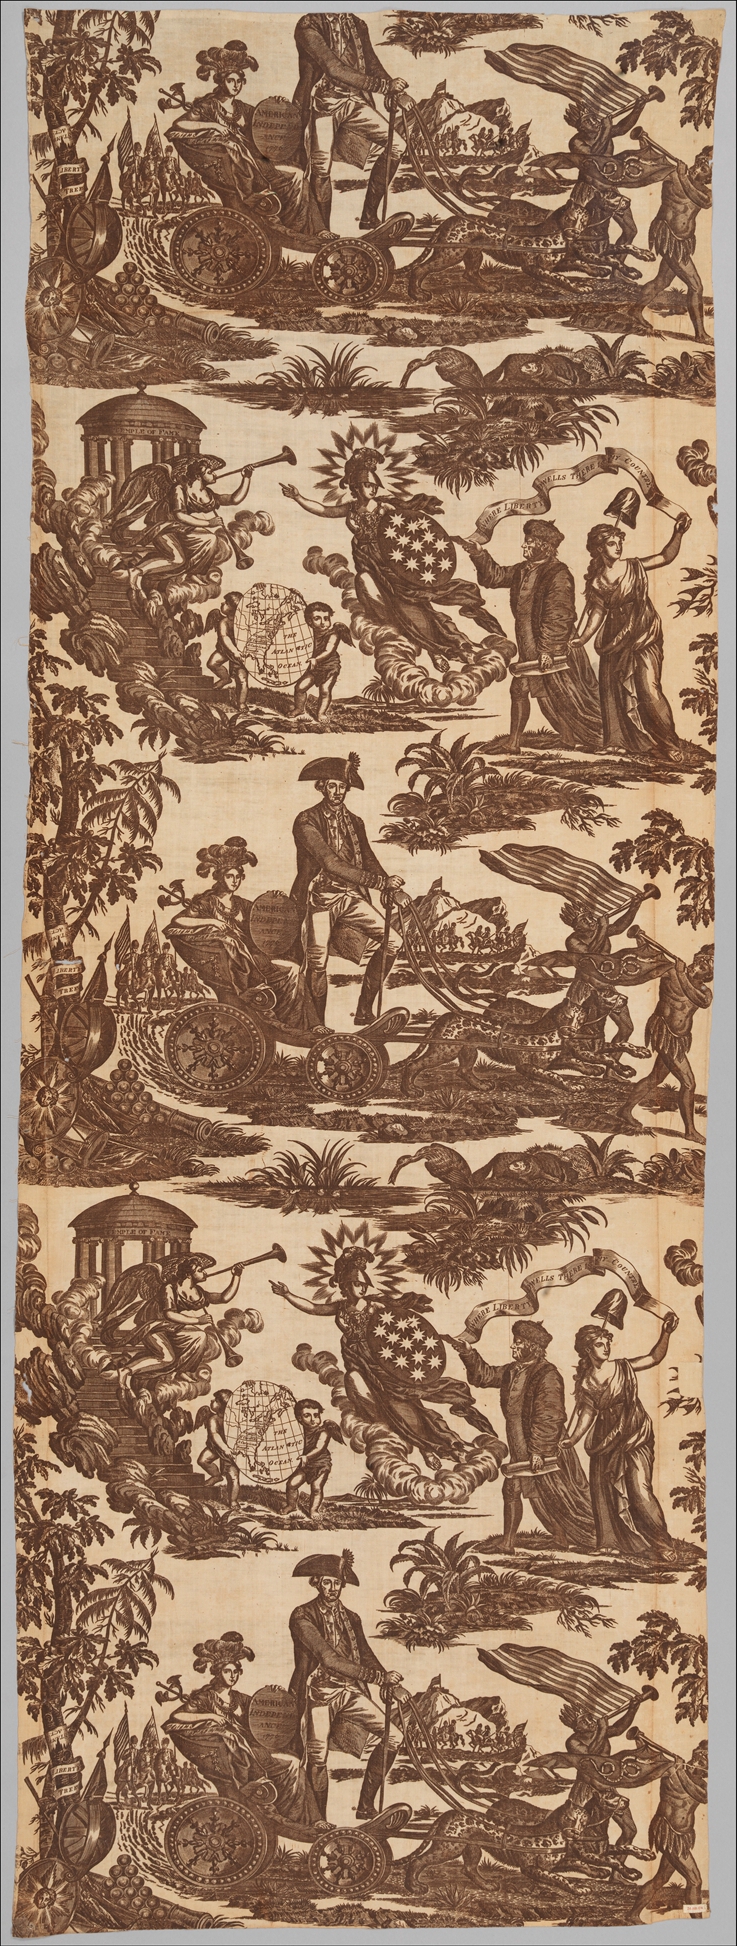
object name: piece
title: Apotheosis of Franklin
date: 1790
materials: cotton, linen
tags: animals,american revolution,men,women,carriages